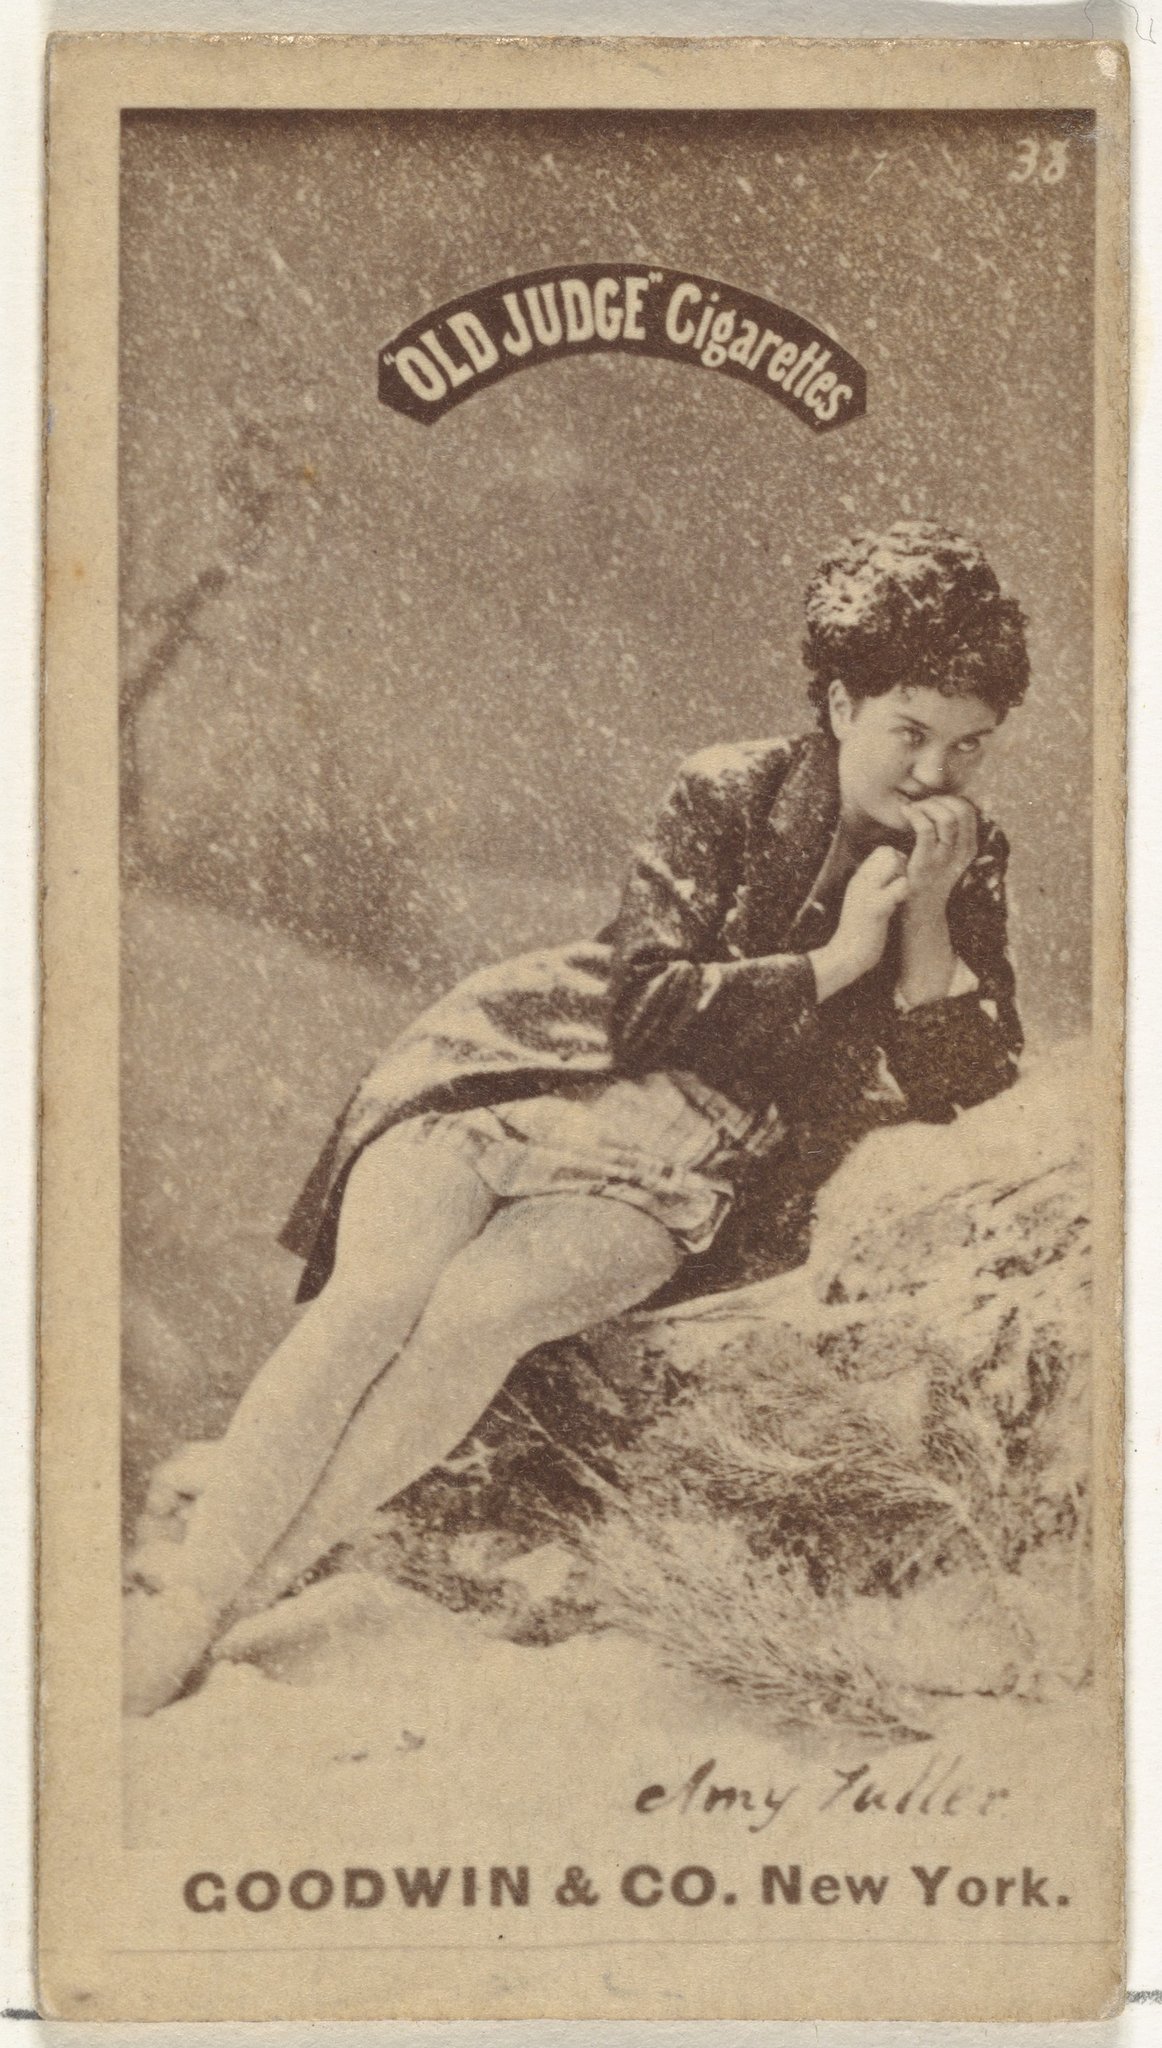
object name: photograph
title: Amy Fuller, from the Actors and Actresses series (N171) for Old Judge Cigarettes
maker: goodwin & company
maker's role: publisher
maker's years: 1850-1950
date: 1886-1890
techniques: albumen silver print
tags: women,actresses